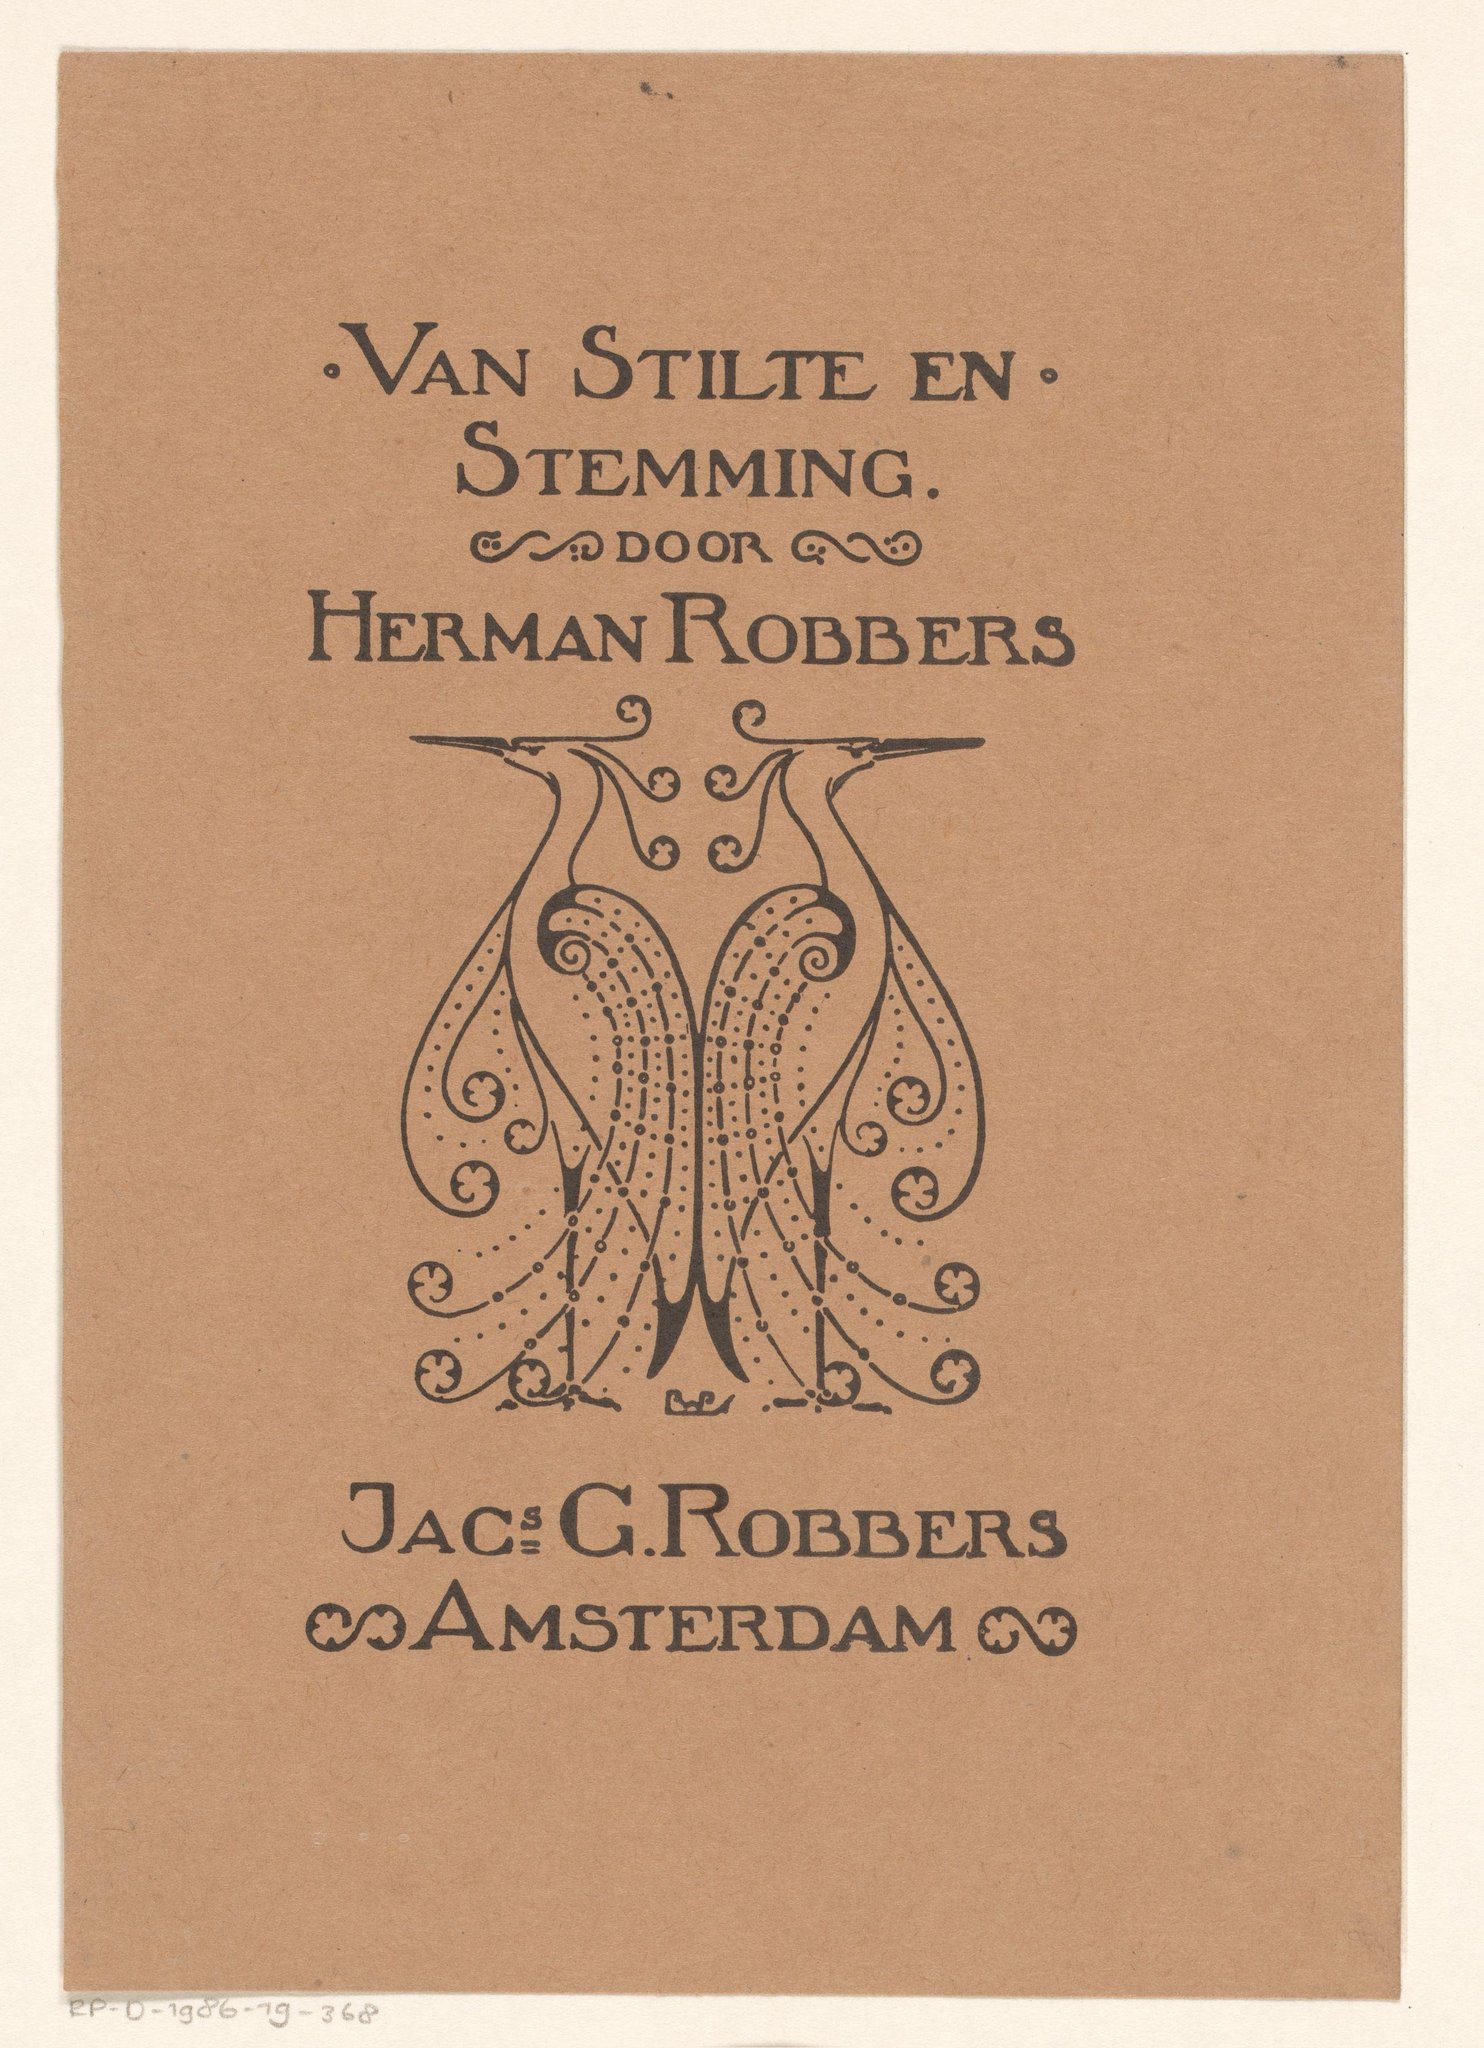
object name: photomechanical print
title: Bandontwerp voor: Herman Robbers, Van stilte en stemming, 1905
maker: reinier willem petrus de vries (1874-1953)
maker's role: draughtsman, print maker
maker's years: 1874-1953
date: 1905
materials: paper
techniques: printing block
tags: fabulous animals ~ ornamental birds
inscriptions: collector's mark: ‘R:MVS.’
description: Bandontwerp voor: Robbers, Herman. Van stilte en stemming. Amsterdam: Robbers, 1905.